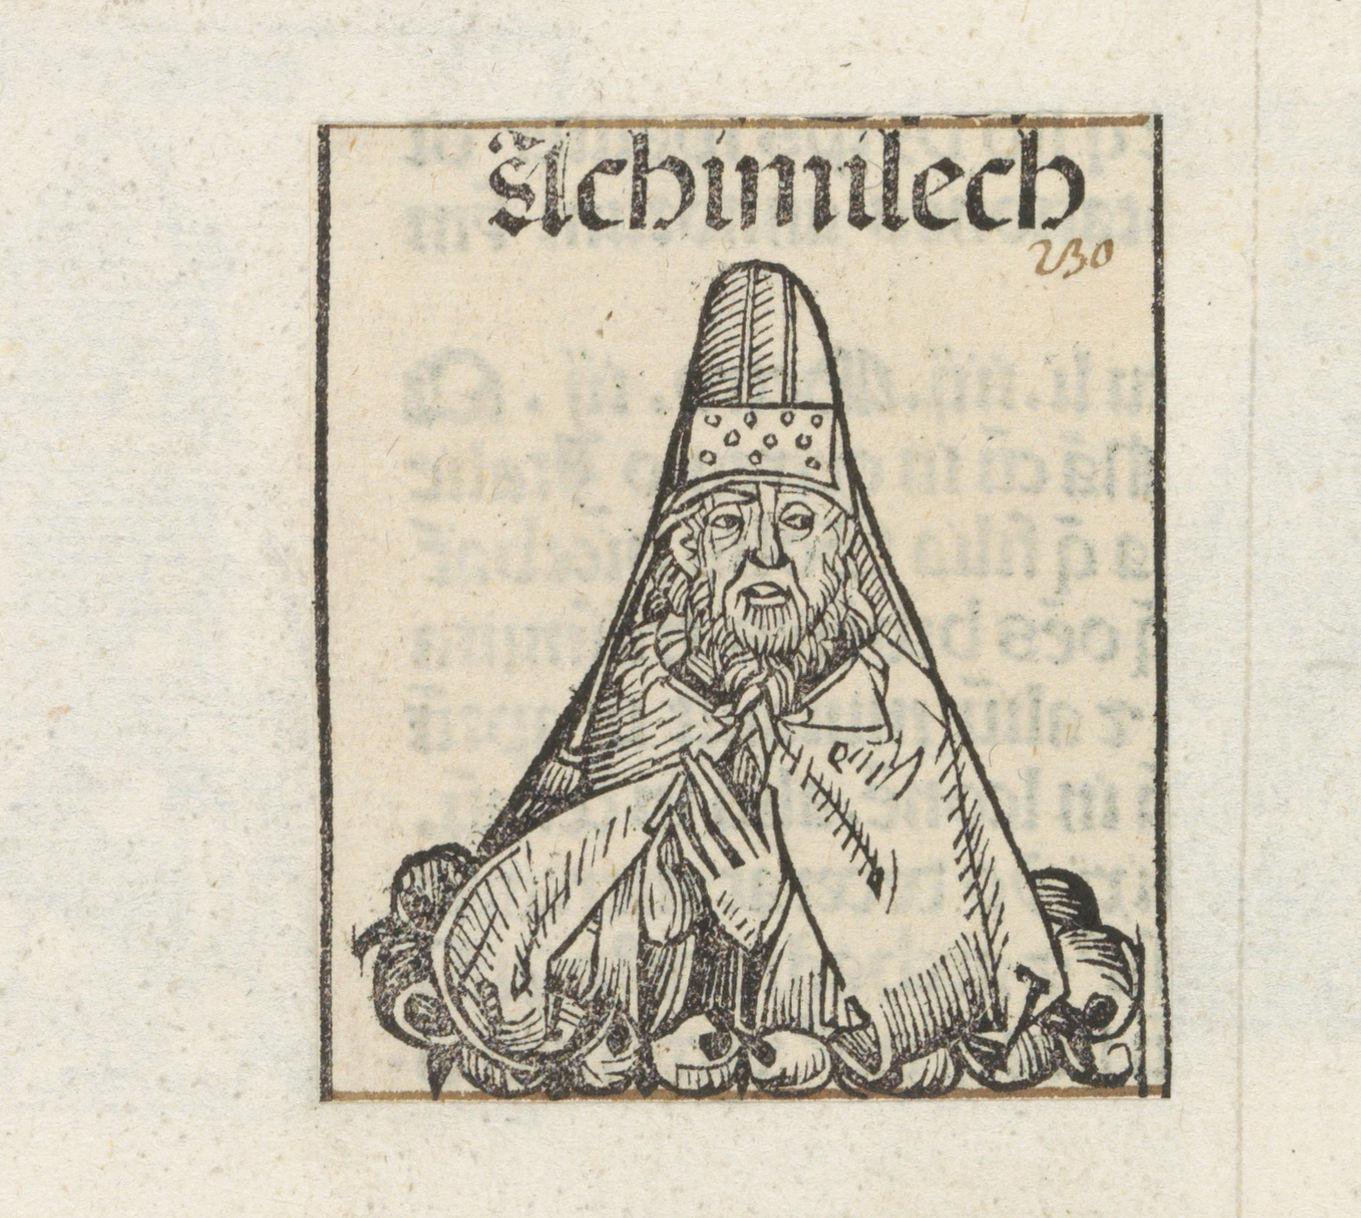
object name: book illustration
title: Achimilech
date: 1493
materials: paper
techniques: letterpress printing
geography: nuremberg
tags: high priest ~ hierarchy of priests, persons from the old testament (not in biblical context, nor occurring in legendary/historical extensions included in division 71)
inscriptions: inscription: ‘230’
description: Een bloemkelk met een man in priesterkledij, naar voren gericht. De tekst identificeert hem als Achimelech, hogepriester. De voorstelling is onderdeel van de opeenvolging priesters in de Liber Chronicarum. De prent maakt deel uit van een album.